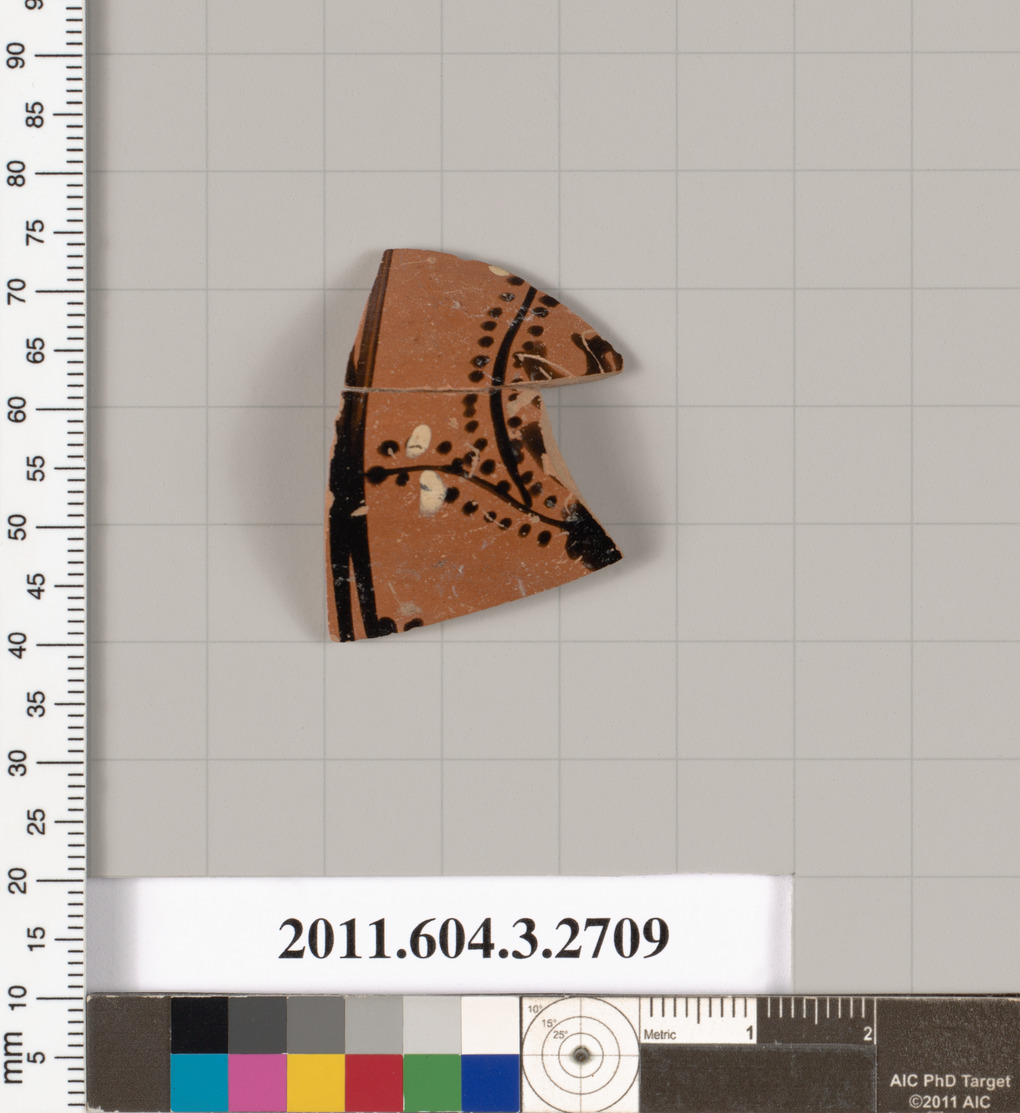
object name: oinochoe fragment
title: Terracotta fragment of an oinochoe (jug)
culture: greek, attic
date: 510-500 BCE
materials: terracotta